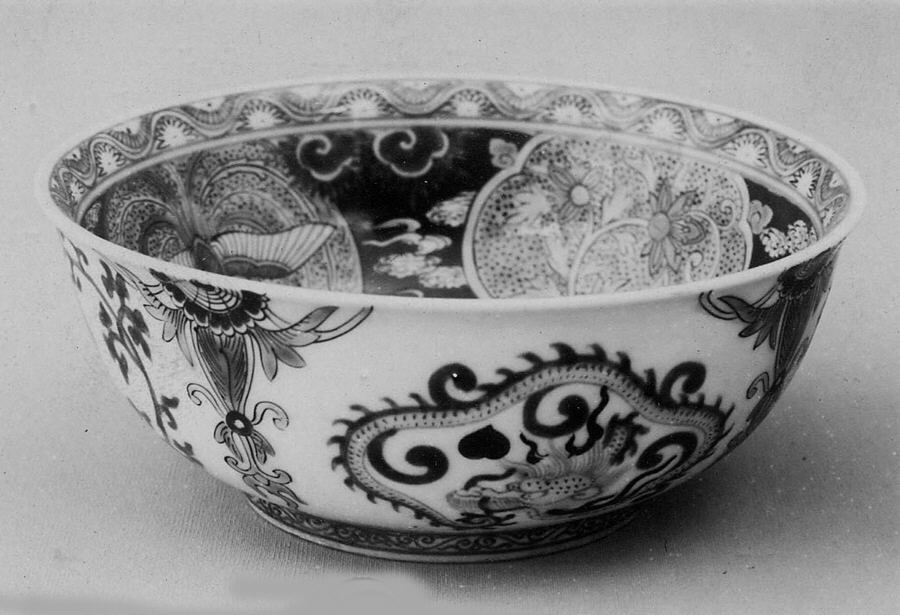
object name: bowl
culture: japanese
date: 1700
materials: enamel, glaze, porcelain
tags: flowers